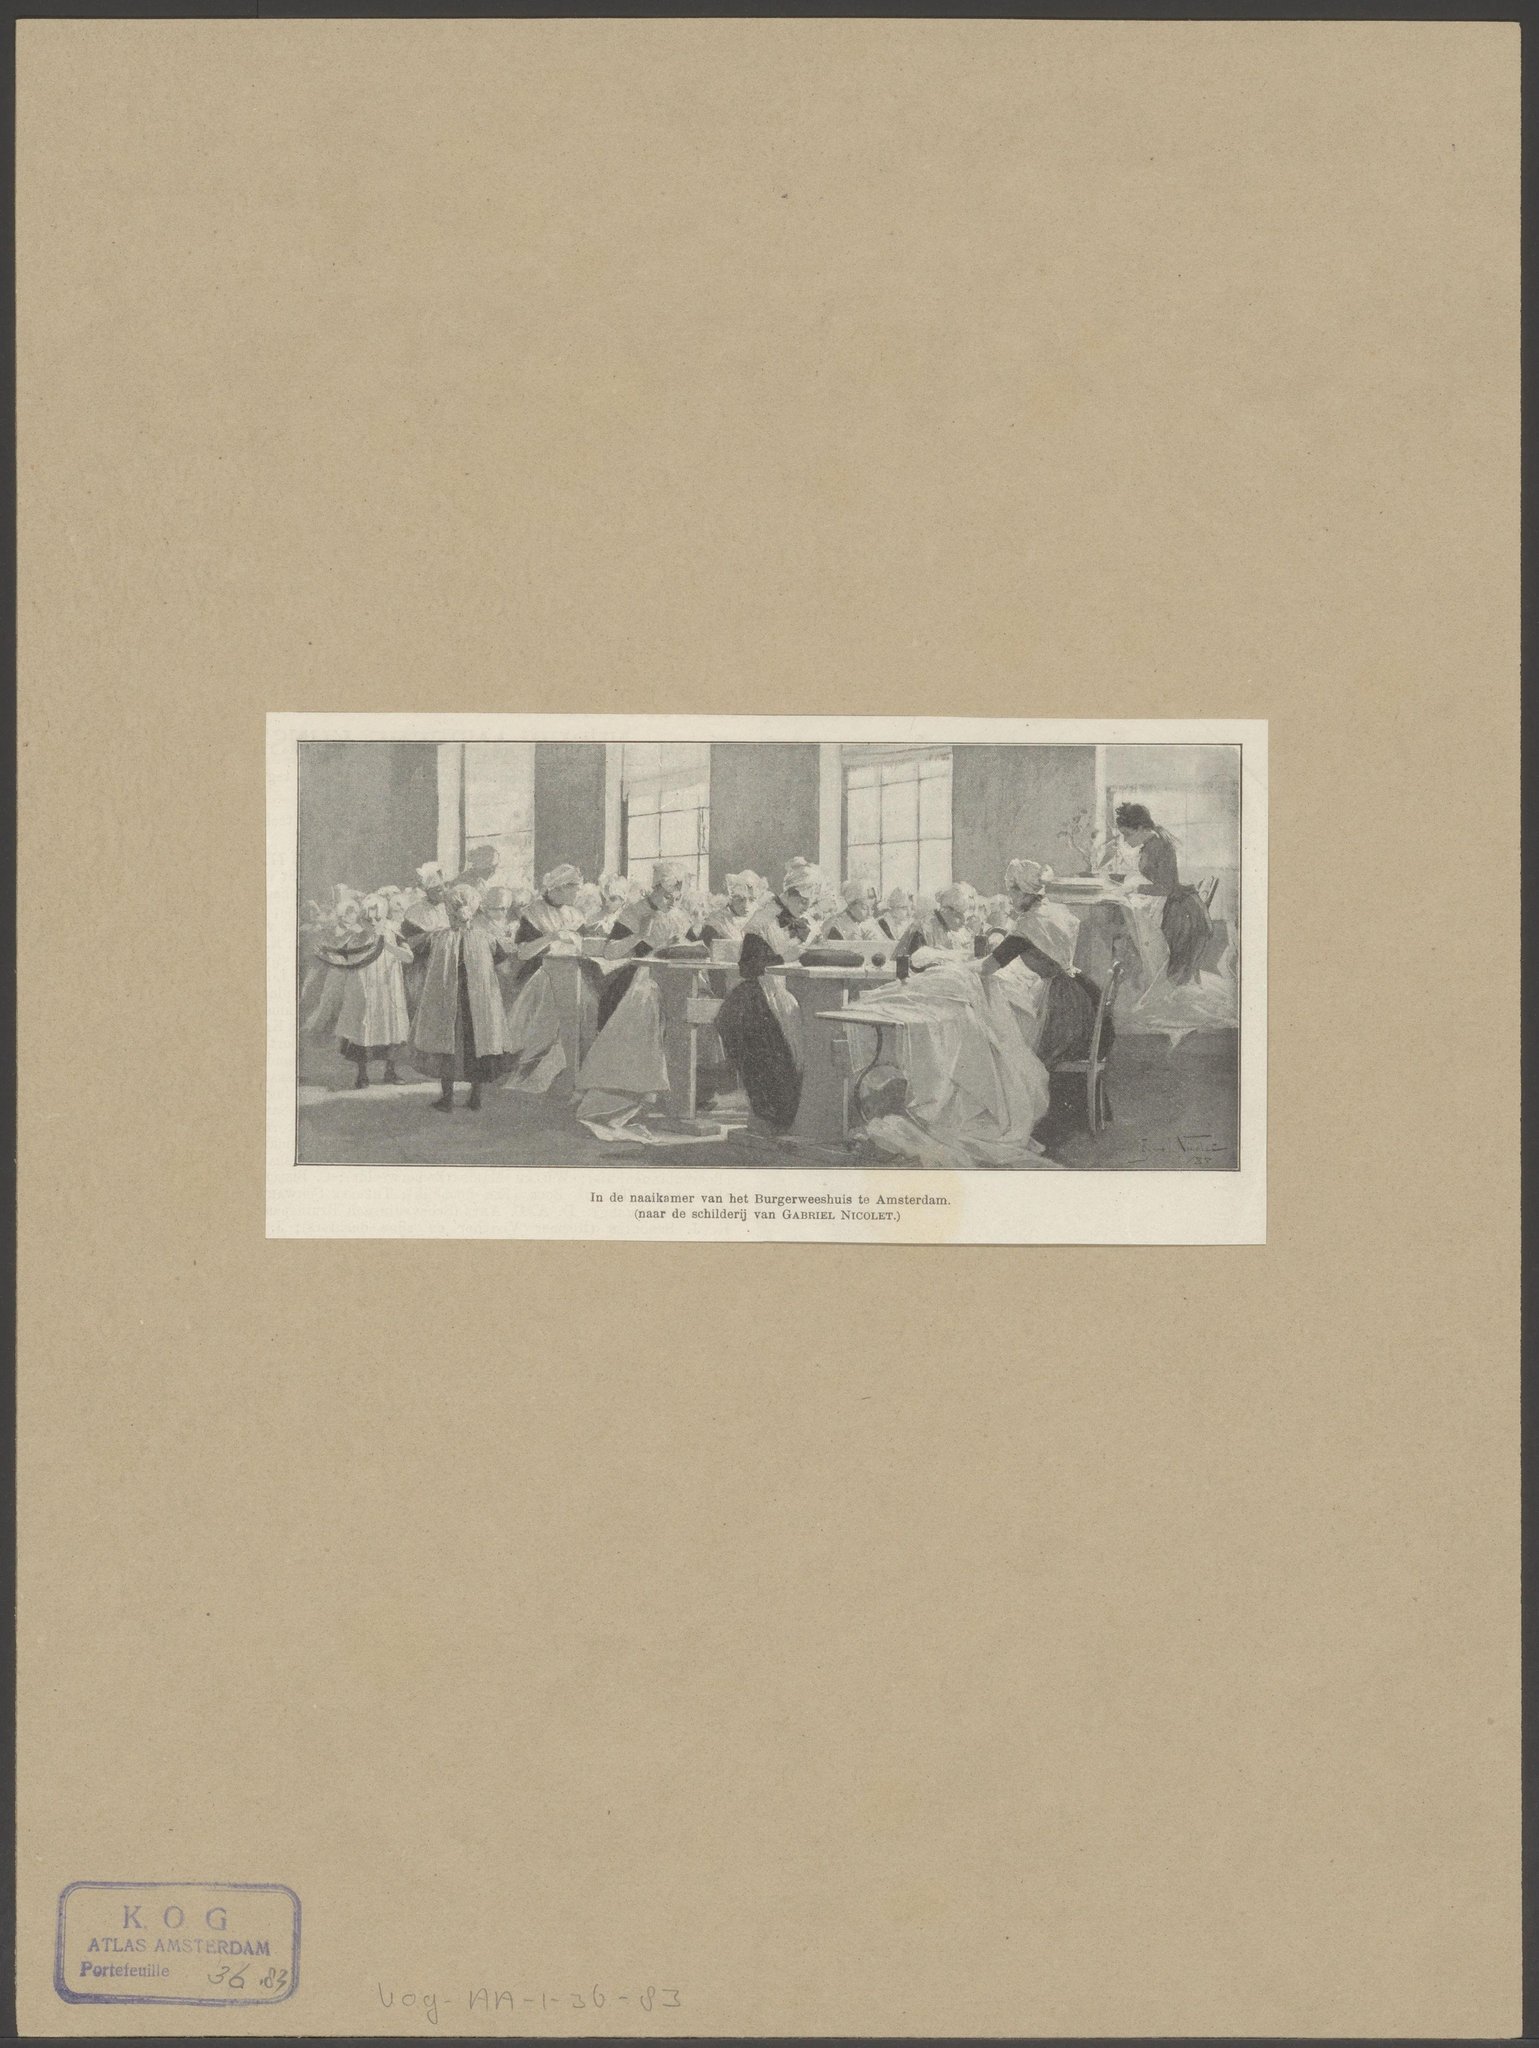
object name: photomechanical print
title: In de naaikamer van het Burgerweeshuis te Amsterdam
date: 1899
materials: paper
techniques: letterpress printing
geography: amsterdam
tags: orphanage, orphans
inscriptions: collector's mark: Lugt 1641b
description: Onderwerpsrubriek binnen de Atlas Amsterdam: Armwezen en liefdadige instellingen: I. Stadsinrichtingen: Burgerweeshuis.